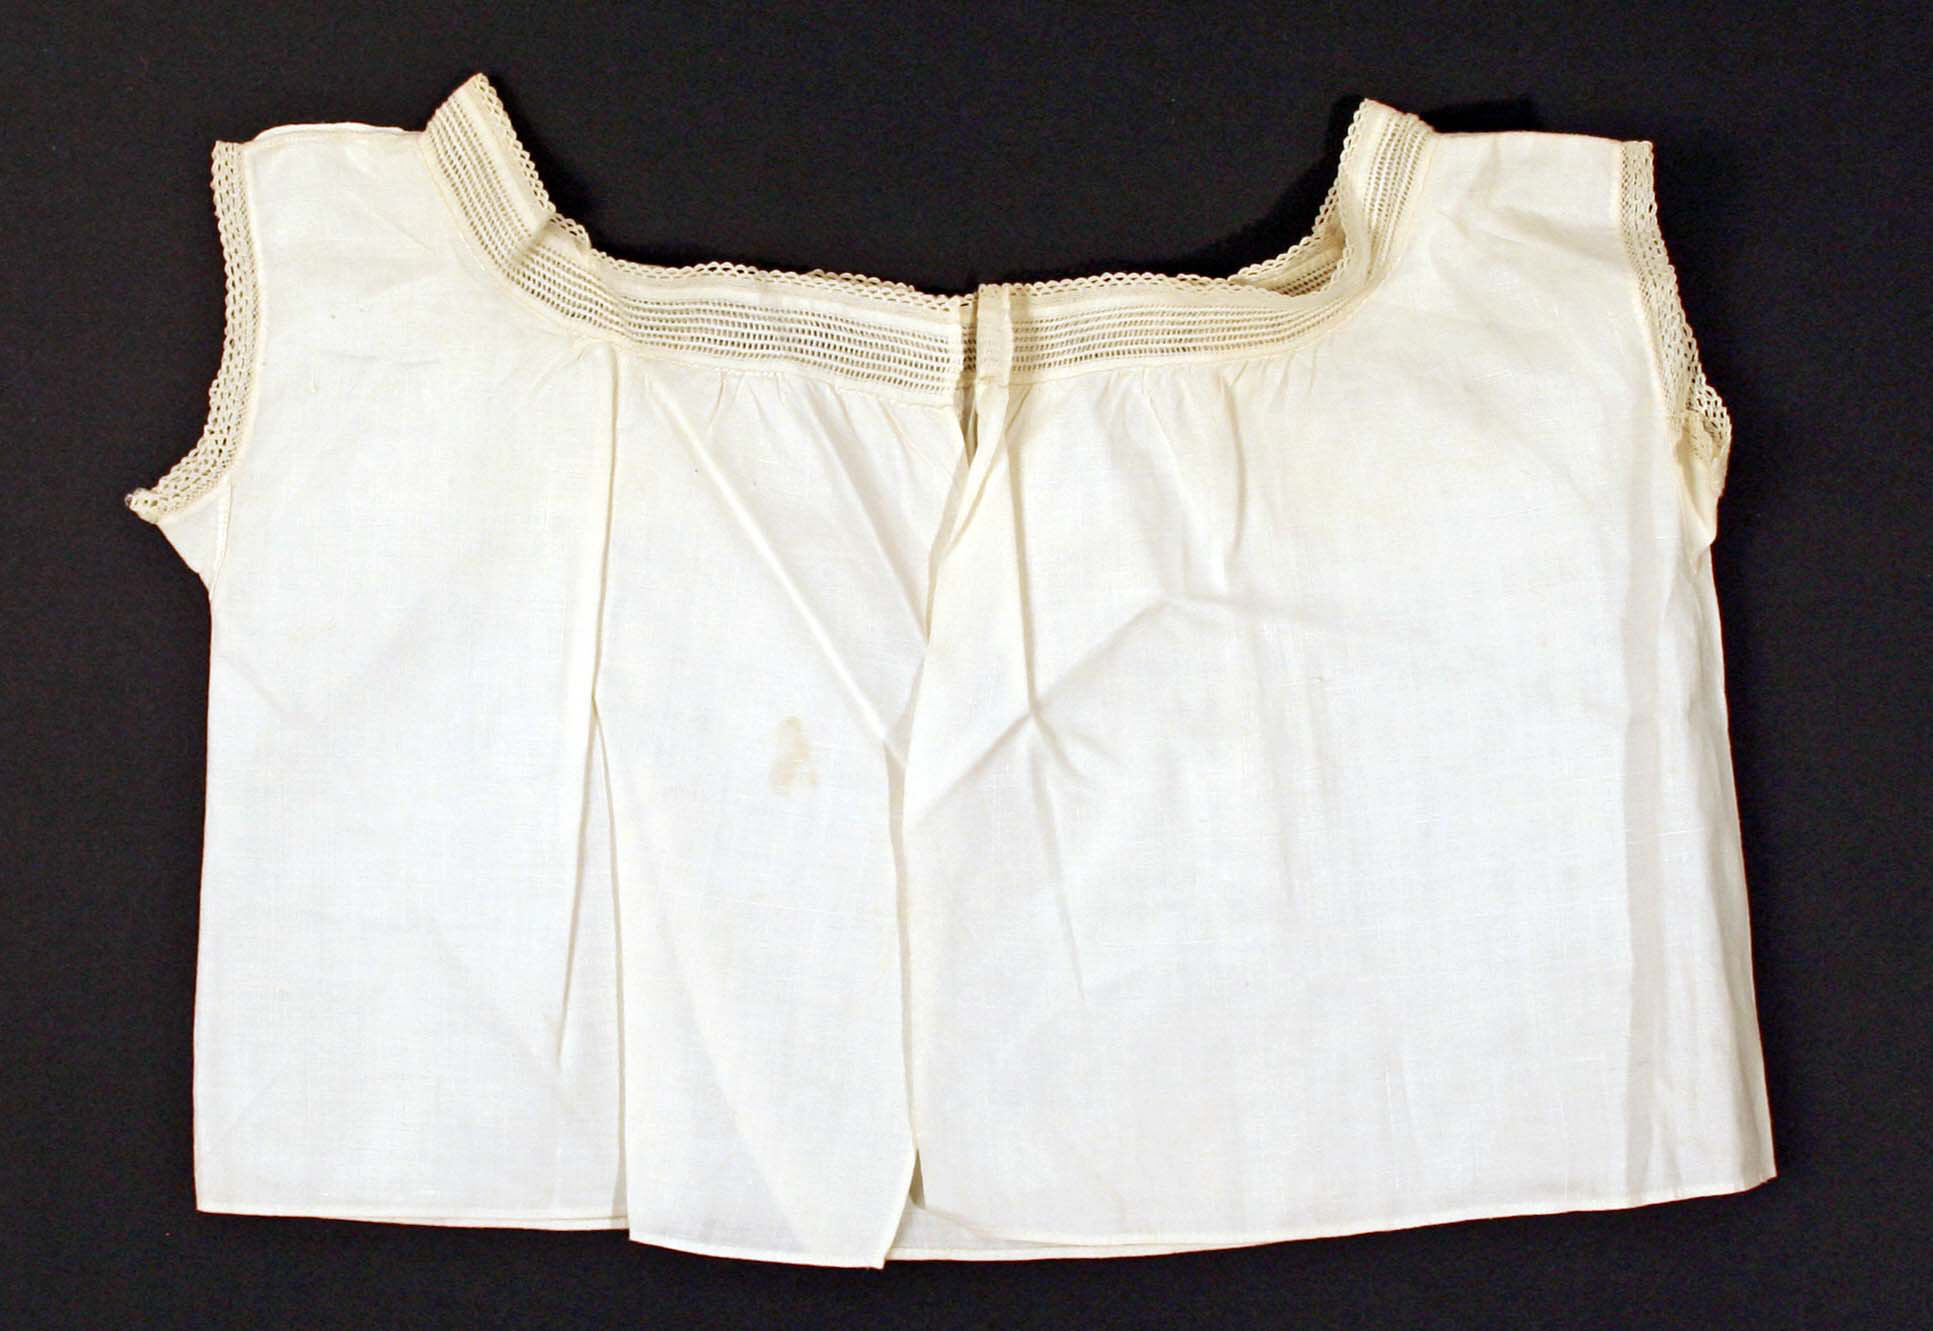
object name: shirt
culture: american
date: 1781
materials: linen